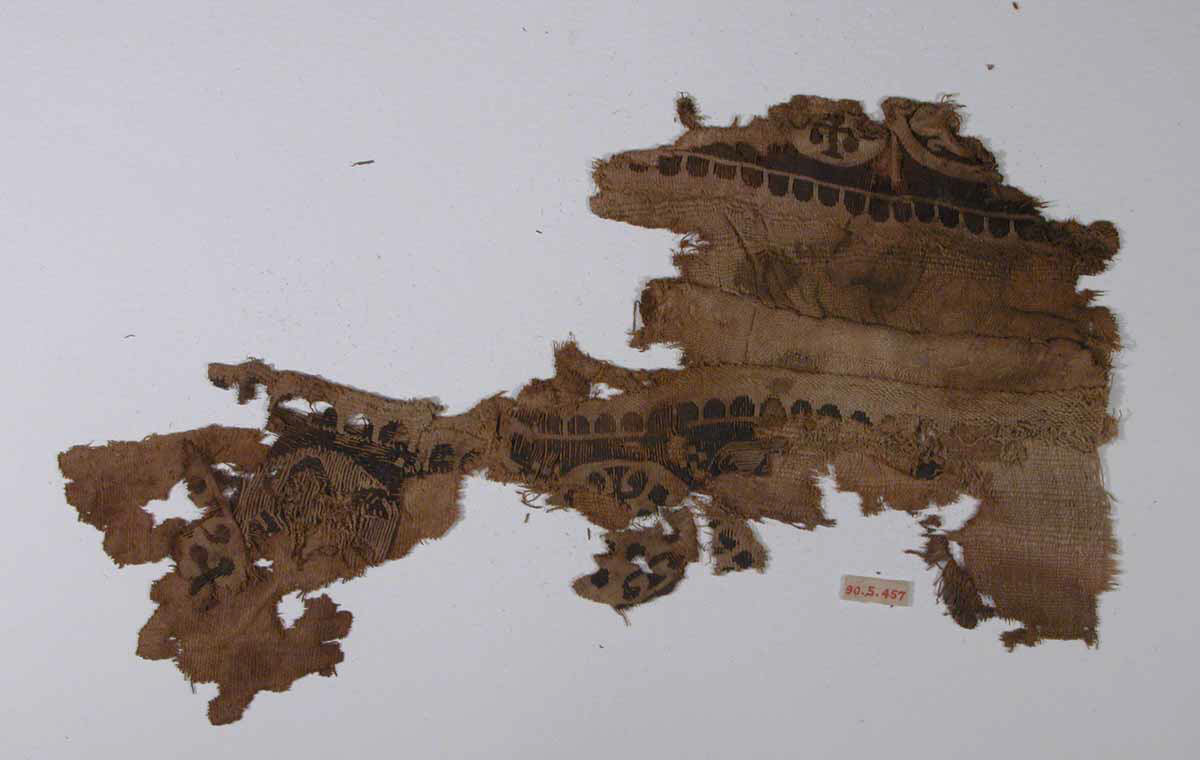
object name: textile fragment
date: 301-400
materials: linen, wool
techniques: weave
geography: egypt